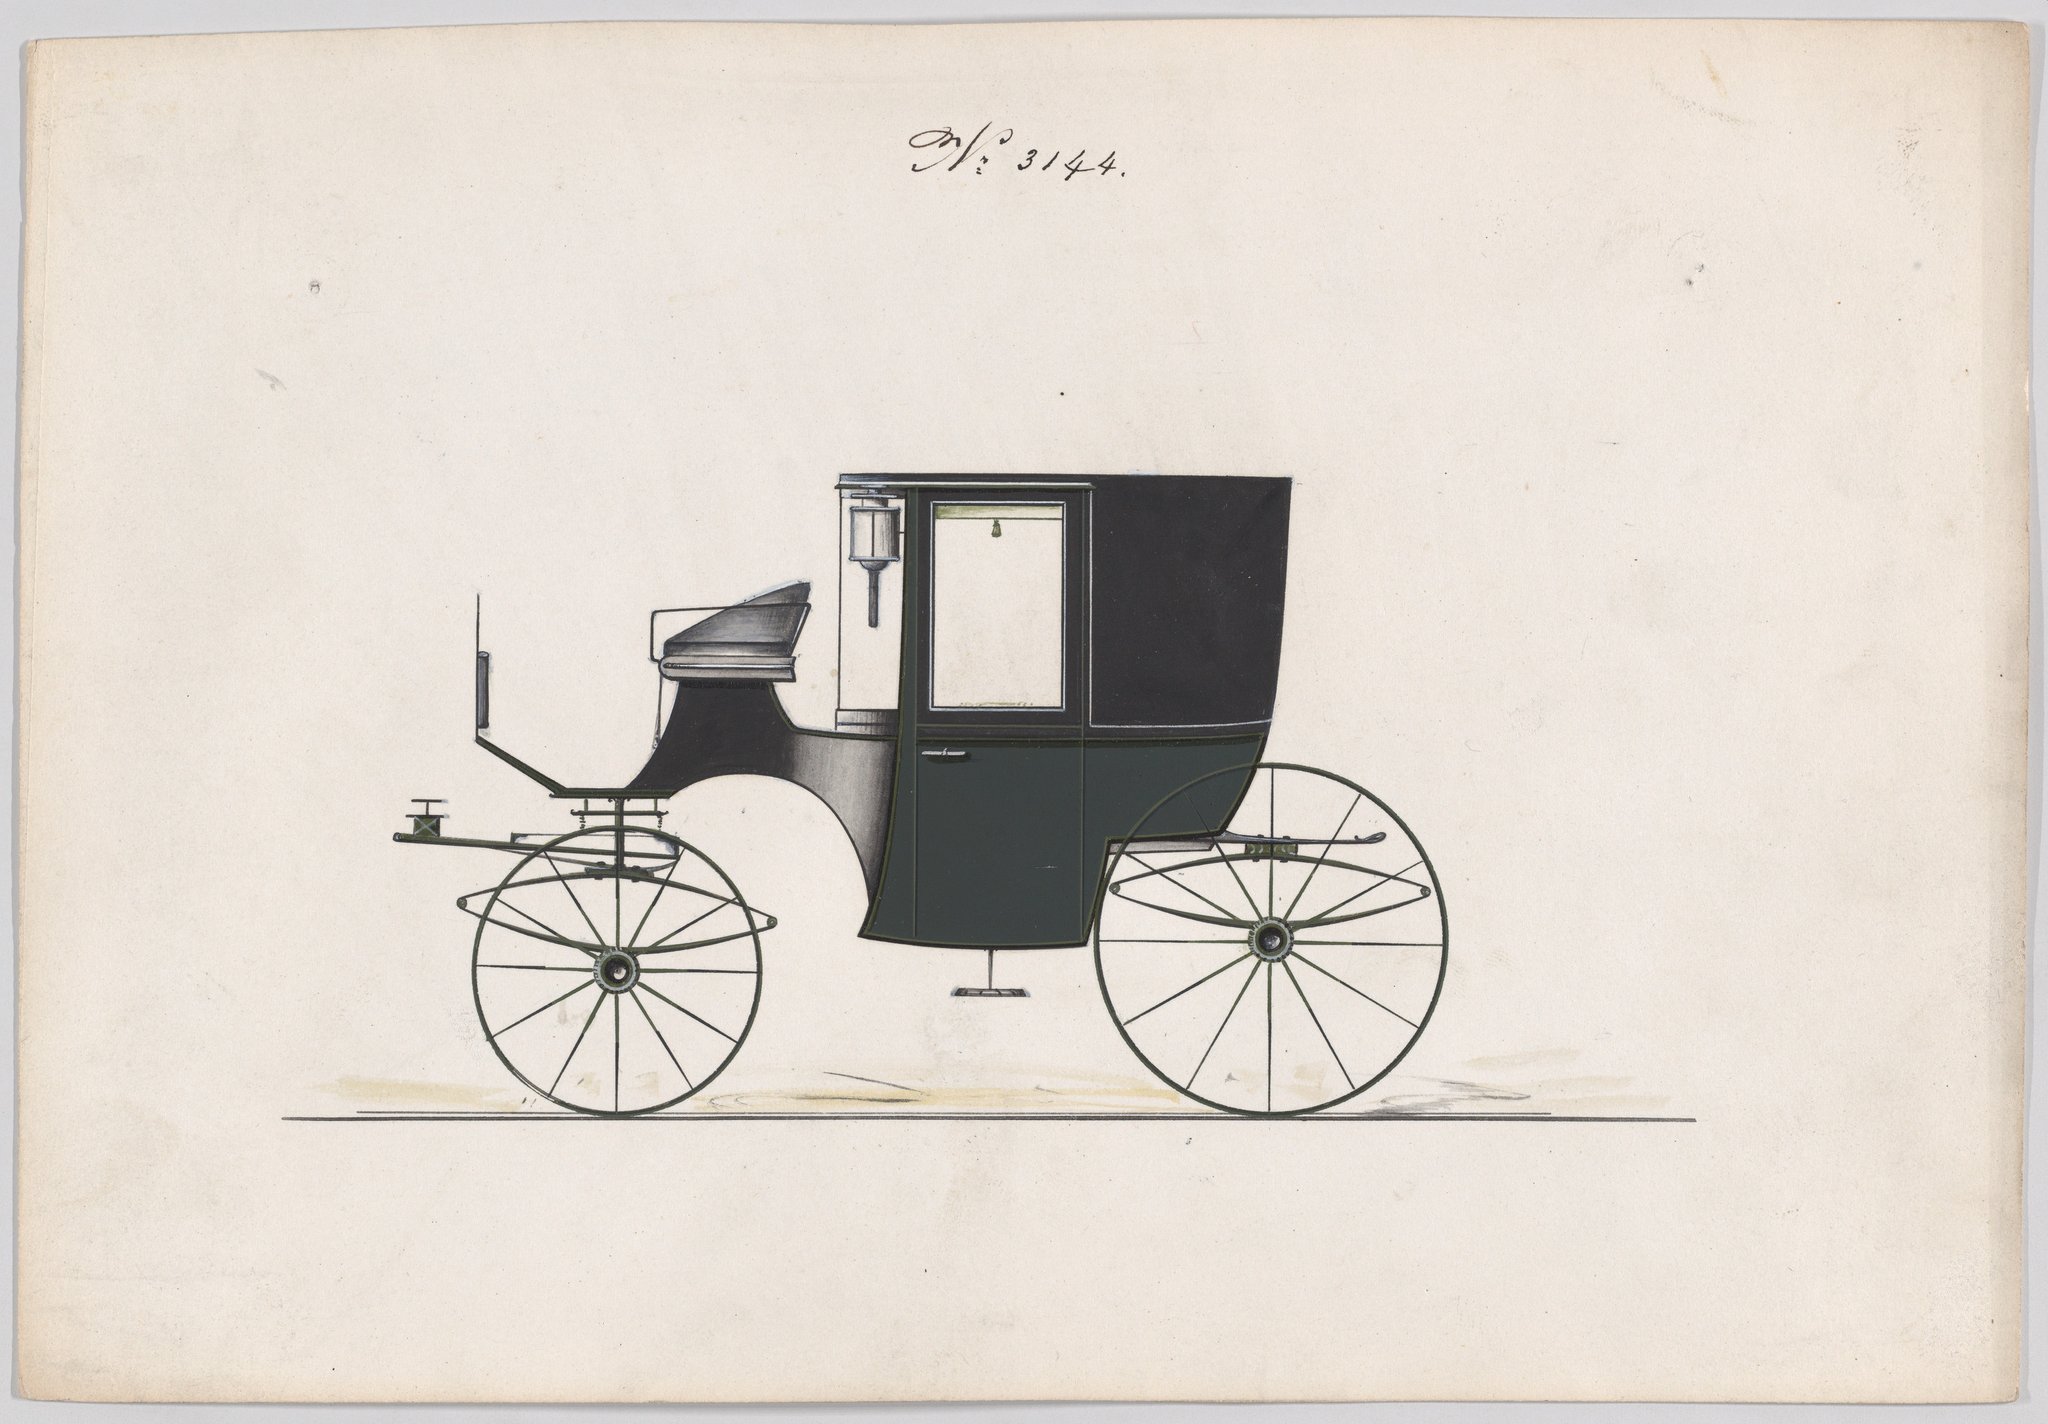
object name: drawing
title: Design for Coupé, no. 3144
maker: brewster & co.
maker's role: manufacturer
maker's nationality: american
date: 1875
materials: gouache, gum arabic, ink, watercolor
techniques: pen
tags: carriages